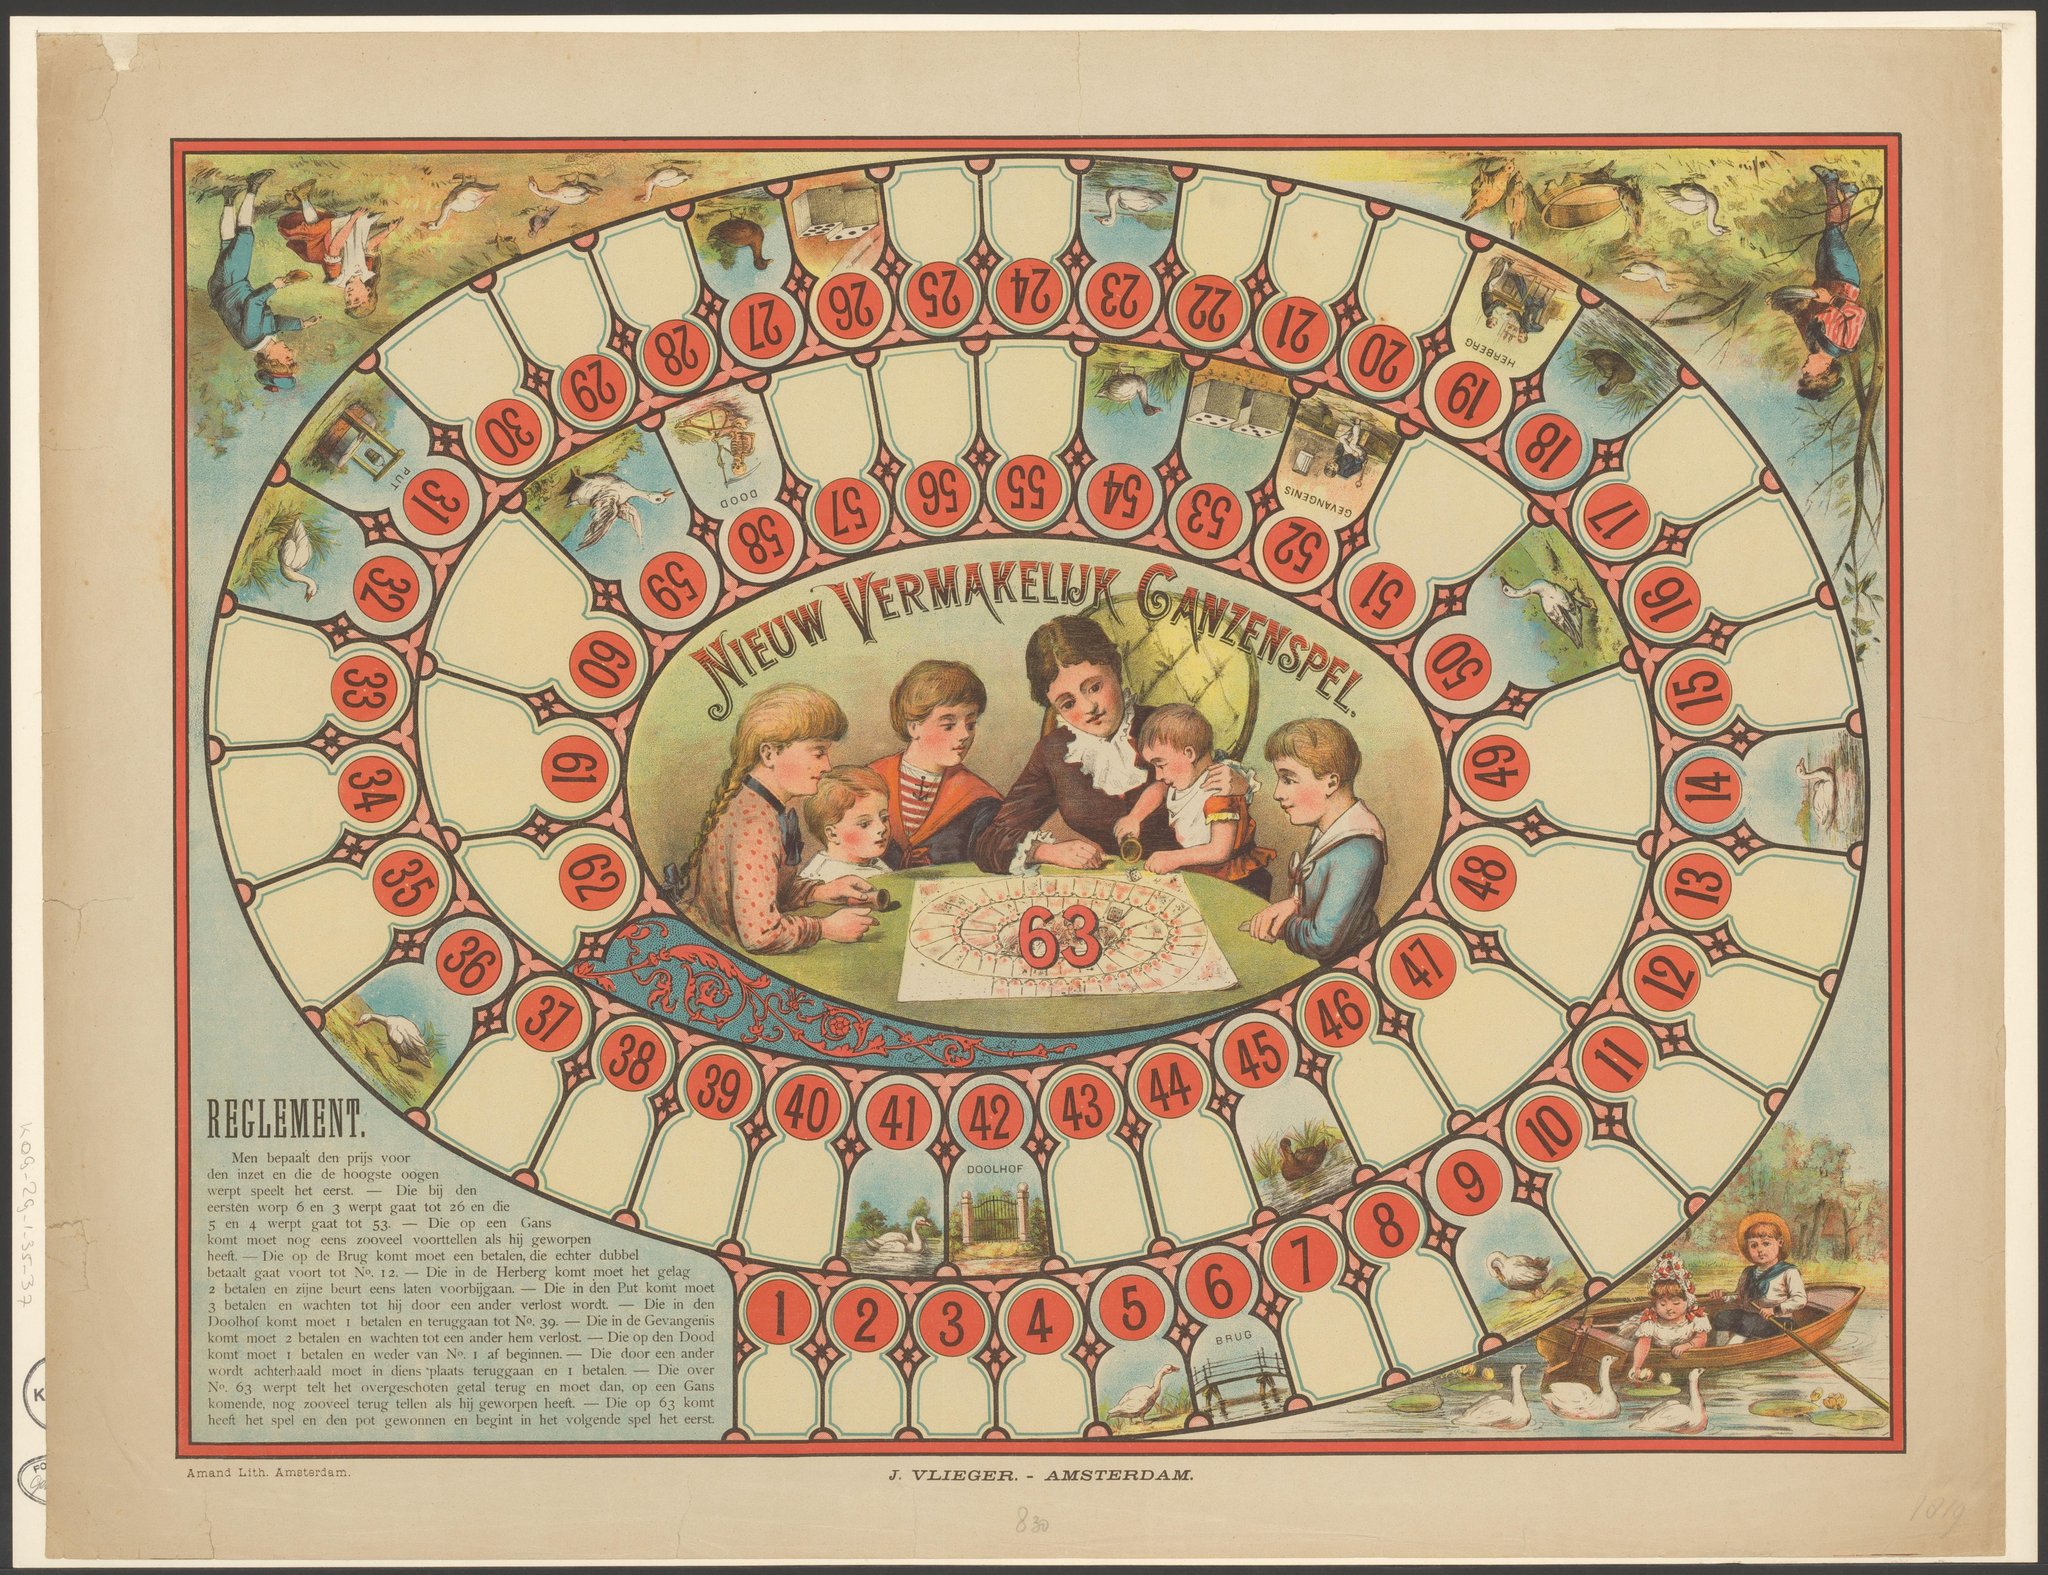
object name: gameboard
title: Nieuw Vermakelijk Ganzenspel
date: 1867-1894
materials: paper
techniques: lithograph, letterpress printing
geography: amsterdam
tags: goose-game, board-games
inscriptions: stamp, collector's mark: Lugt 1641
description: Bordspel met 63 vakken. In het midden een vrouw die met vijf kinderen een bordspel aan het spelen is. Zij heeft het kleinste kind op schoot. Linksonder de spelregels. In de hoeken afbeeldingen van kinderen met ganzen. Onderwerpsrubrieken binnen de Atlas Zeden en Gewoonten: Zeden en gewoonten in engeren zin, Spel en vermaak, Gezelschapsspel II, Ganzenbord en dergelijke.